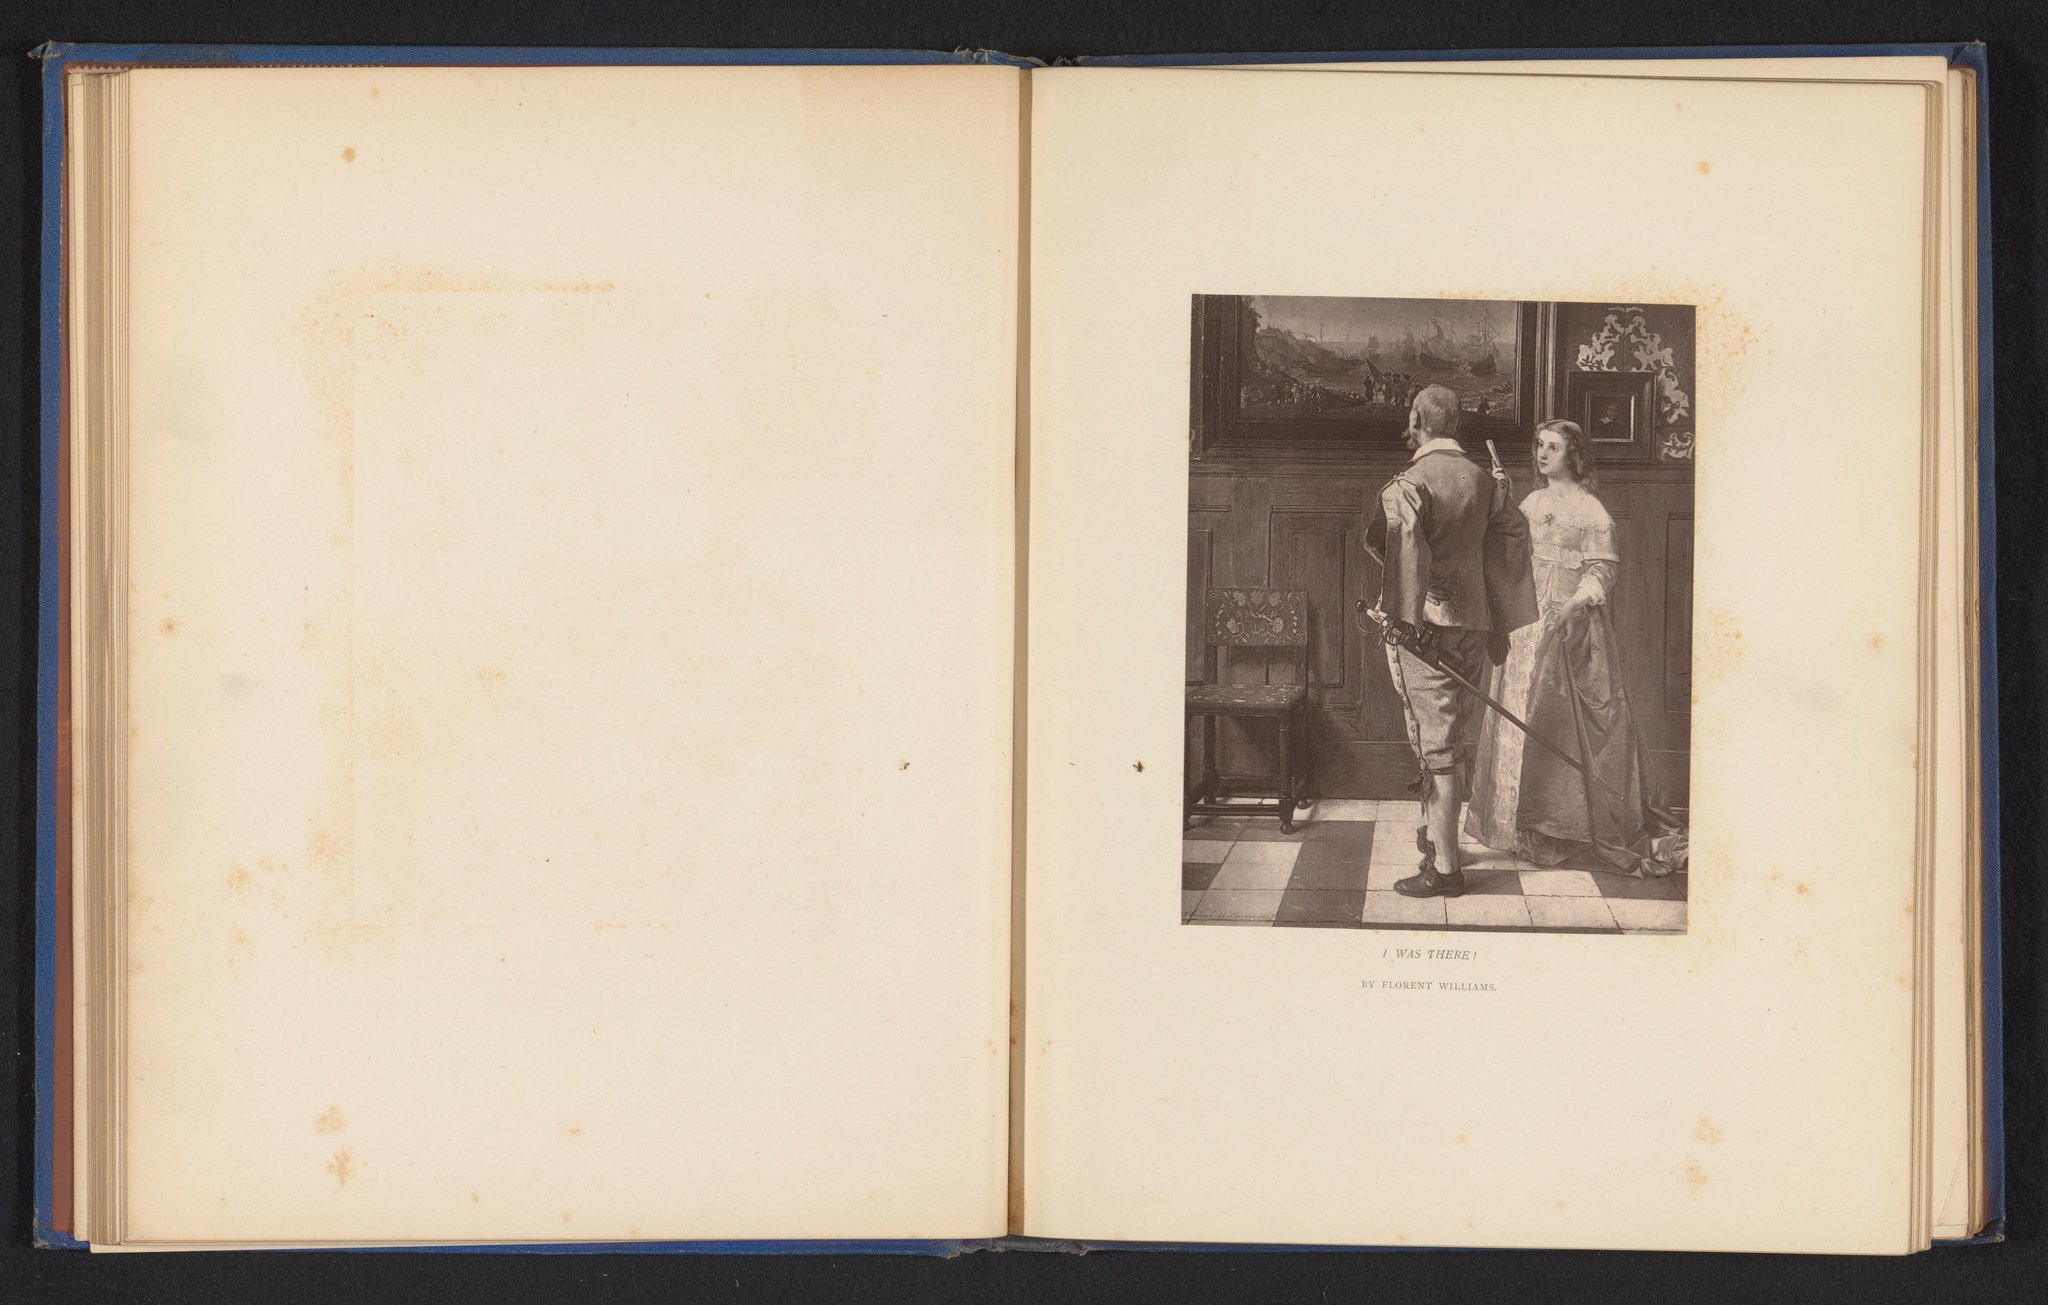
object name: photomechanical print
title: I was there!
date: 1862-1872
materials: paper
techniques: woodburytype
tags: adult woman, adult man, picture, painting, interior ~ representation of a building